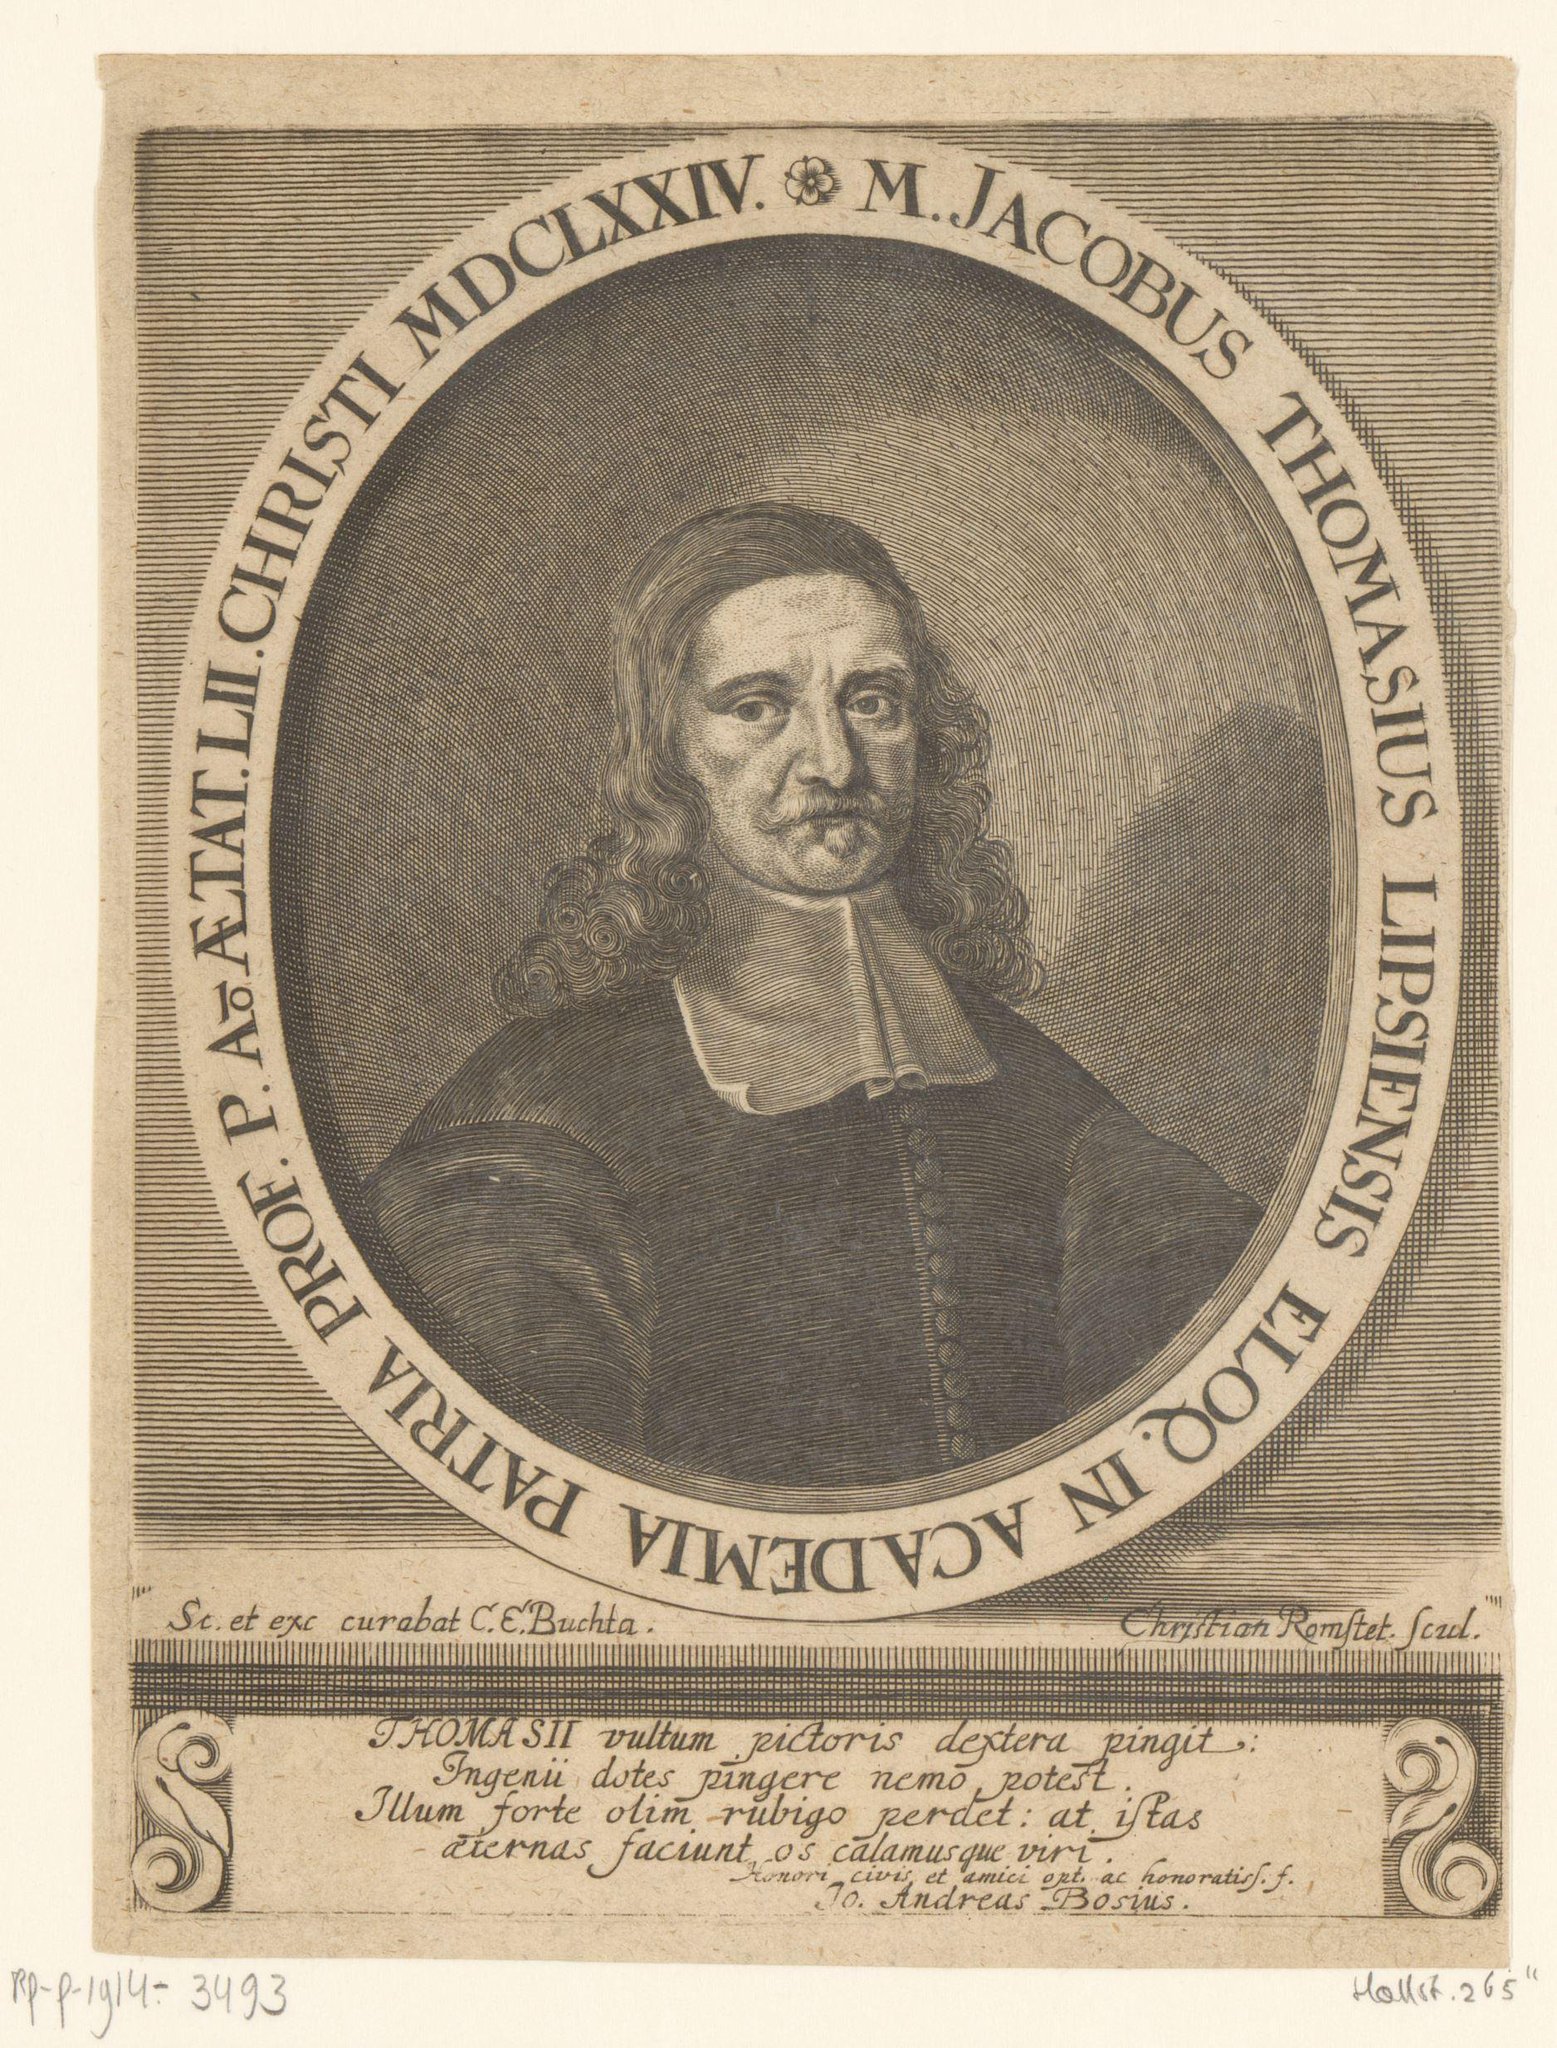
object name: print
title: Portret van Jacob Thomasius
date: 1665-1721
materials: paper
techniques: engraving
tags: jacob thomasius, historical persons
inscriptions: collector's mark: Lugt 2228